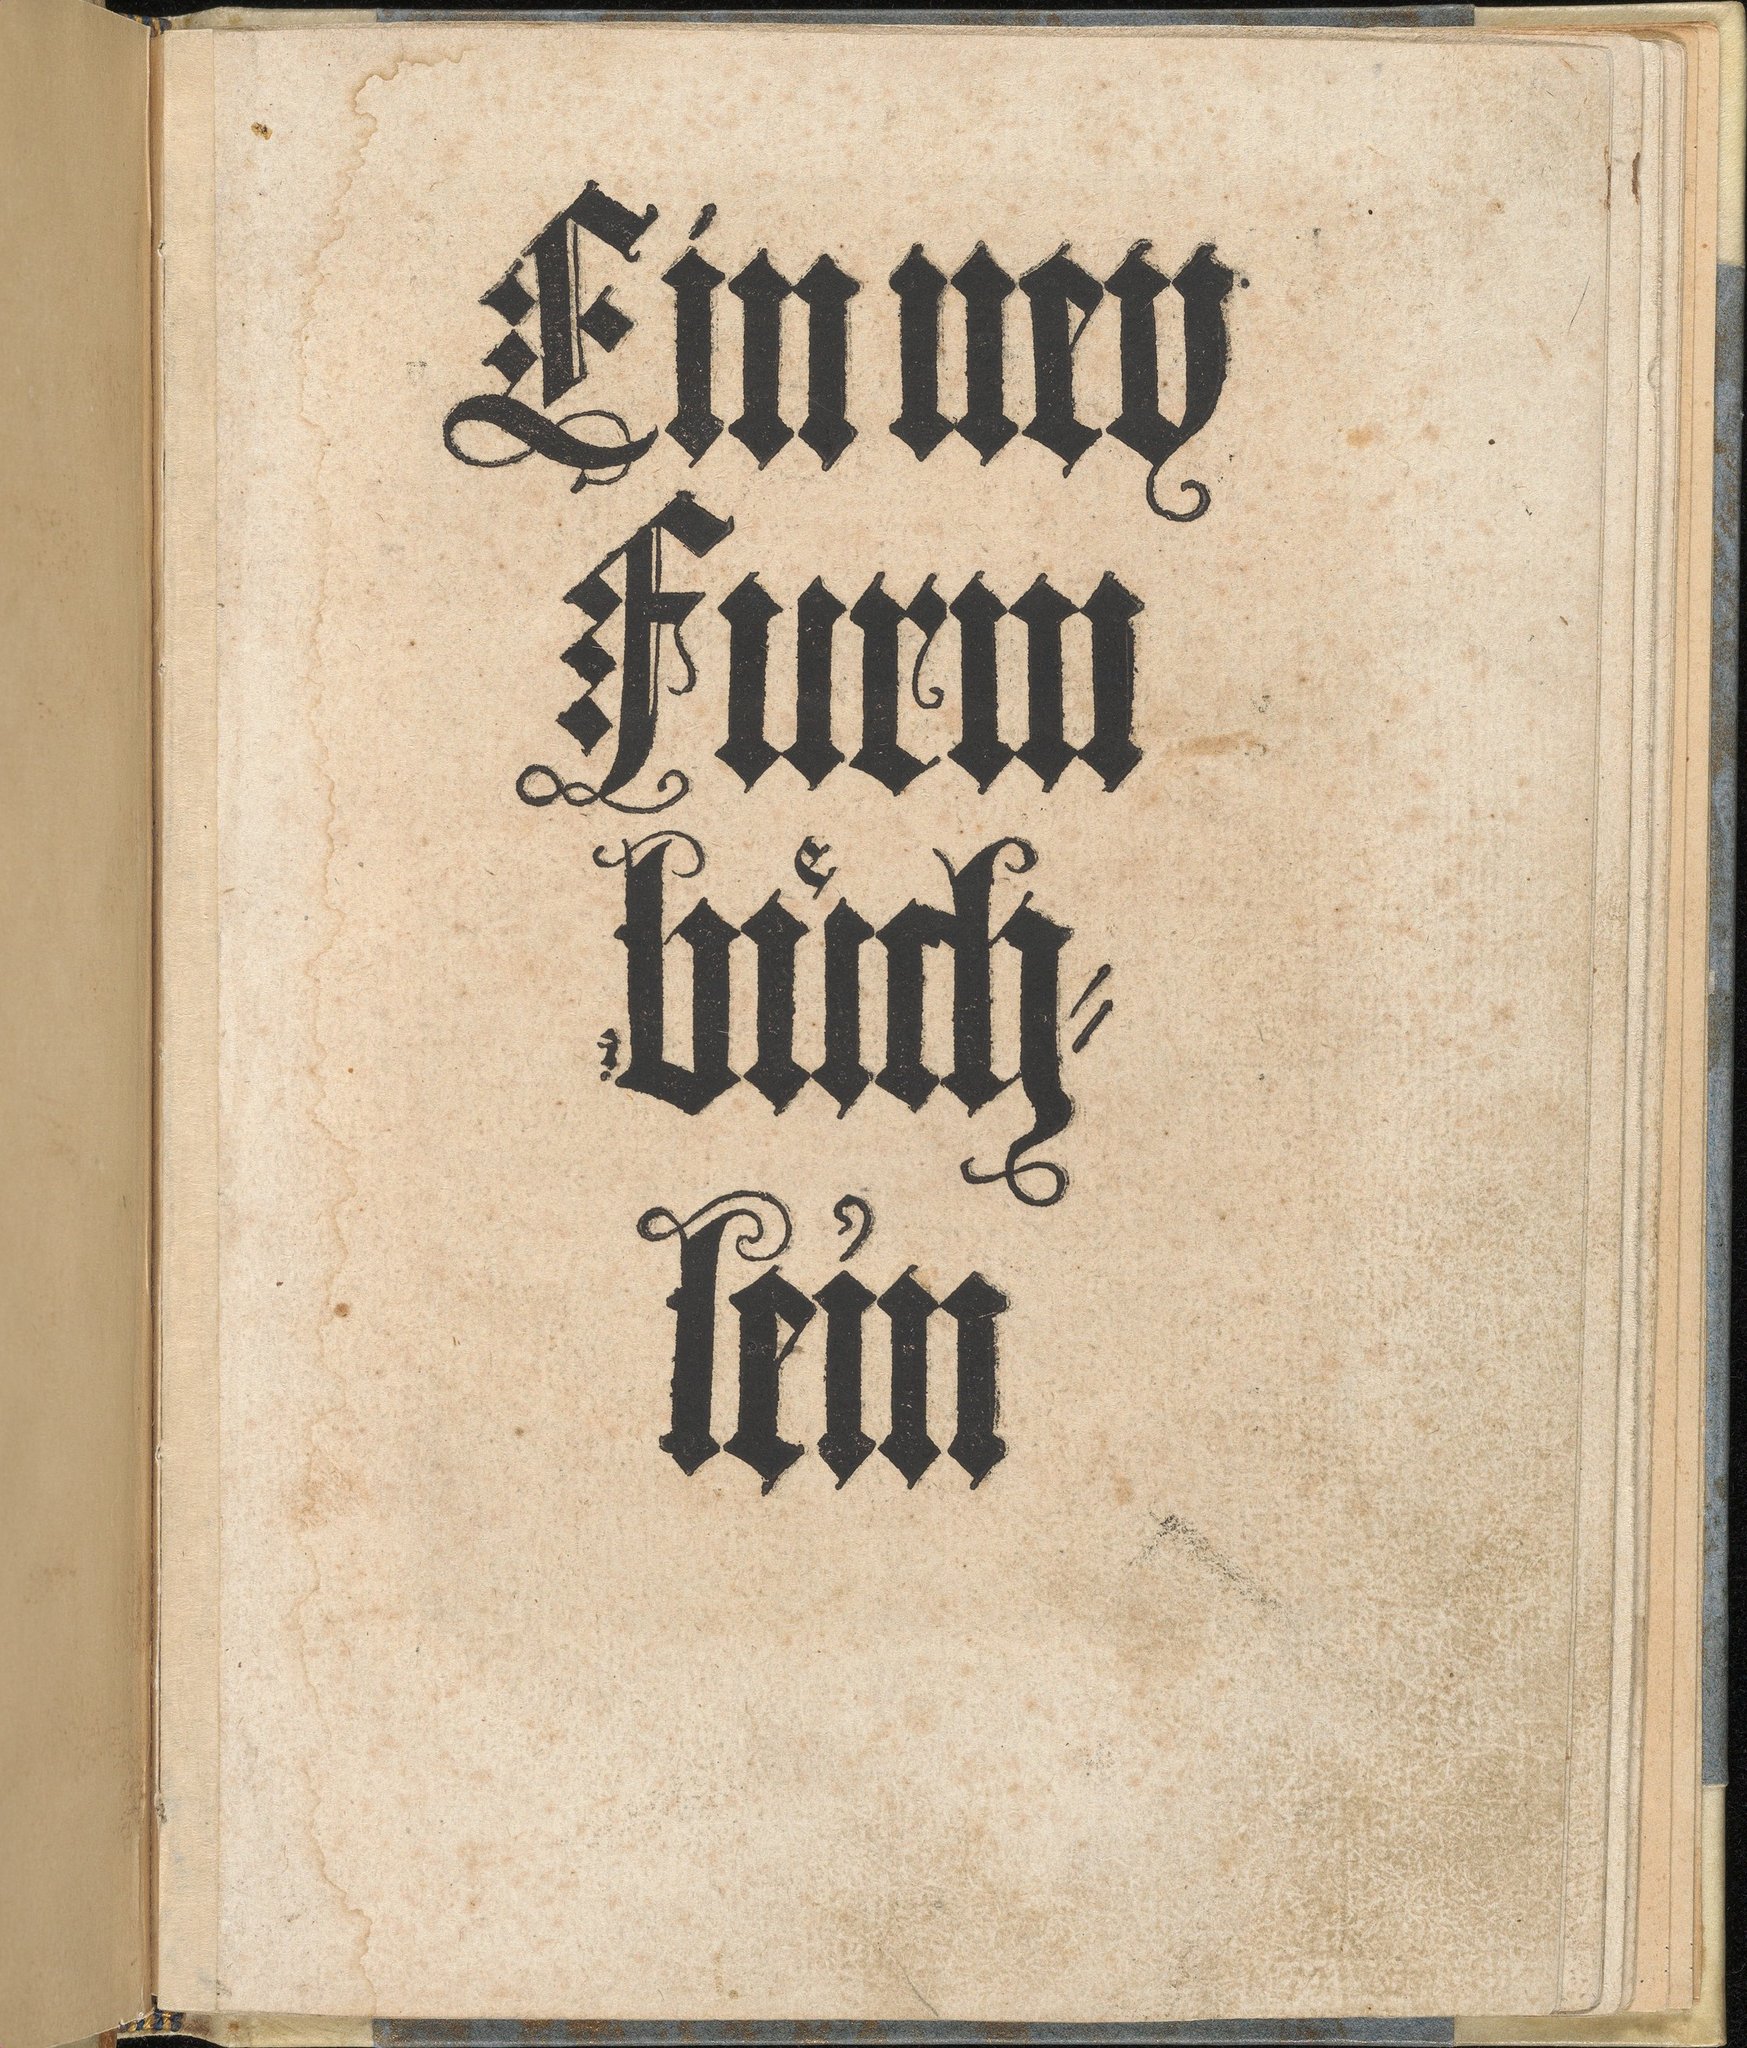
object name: book print ornament architecture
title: Ein ney Furmbüchlein, Title page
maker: johann schönsperger the younger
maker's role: publisher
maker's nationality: german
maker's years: 1490-1550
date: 1525-1529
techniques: woodcut